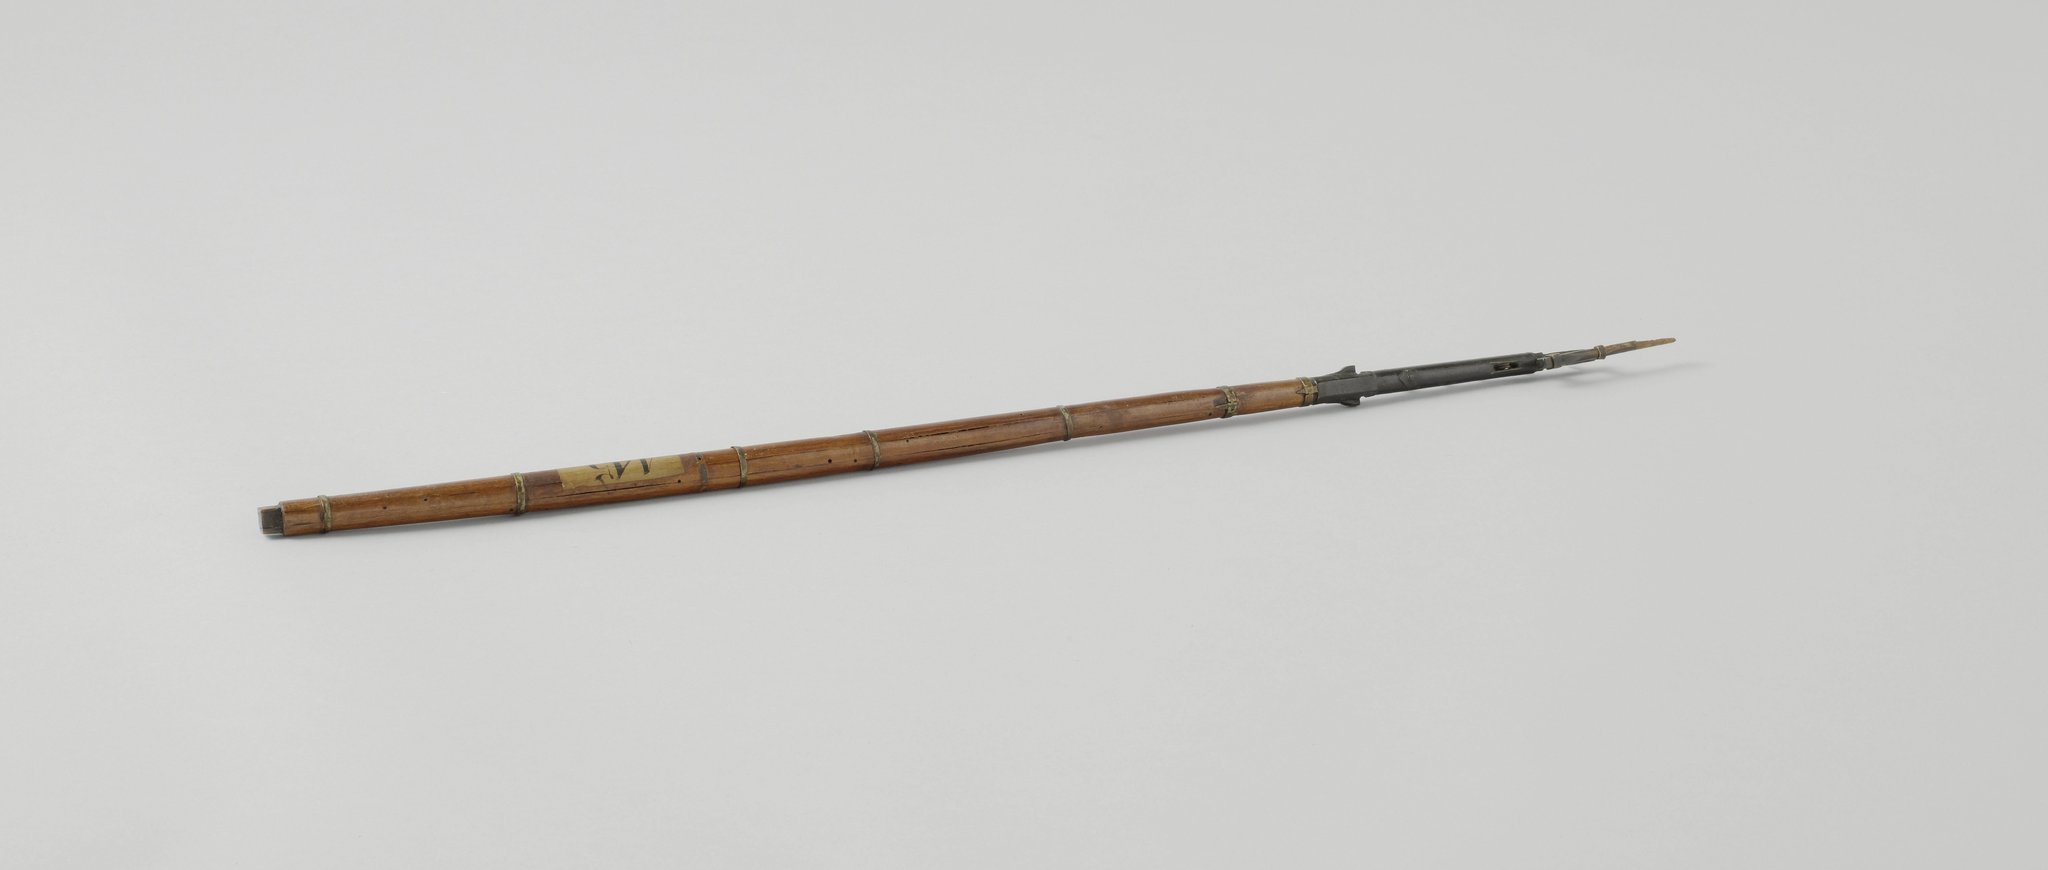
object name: demonstration model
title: Model of a Made Mast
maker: Anonymous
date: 1780-1840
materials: brass, paint, wood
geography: netherlands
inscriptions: label: ‘145’ former inventory label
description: Deze mast was waarschijnlijk bestemd voor een spriettuig.